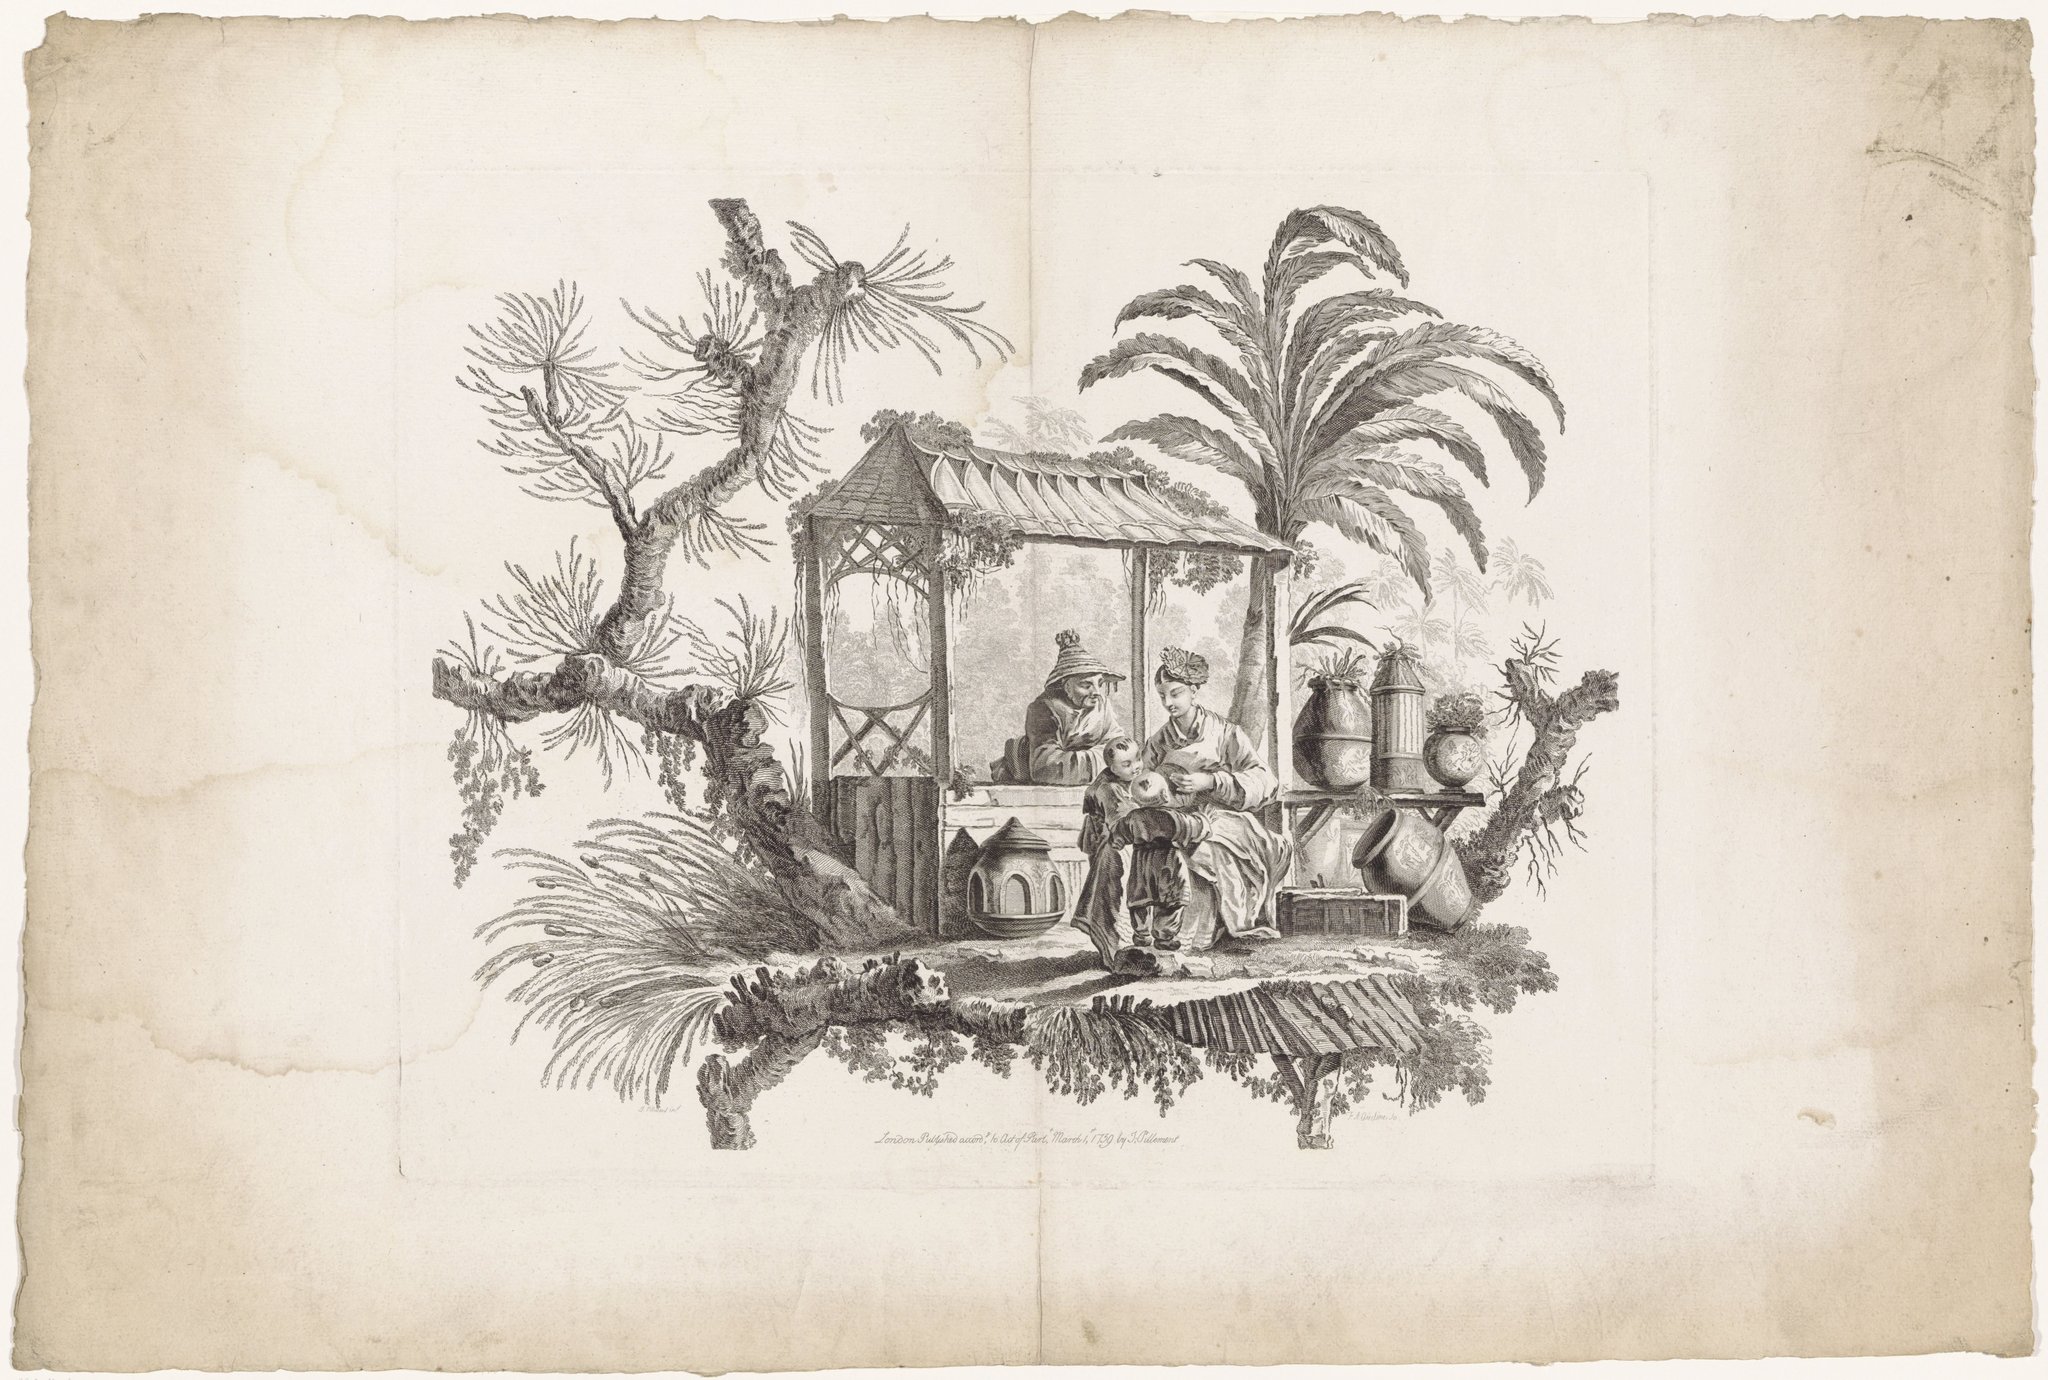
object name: print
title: Chinees gezin bij een overkapping omringd door begroeiing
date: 1759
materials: paper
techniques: engraving, etching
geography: london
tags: landscapes, chinese, pastorals, arcadian scenes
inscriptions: collector's mark: Lugt 2228